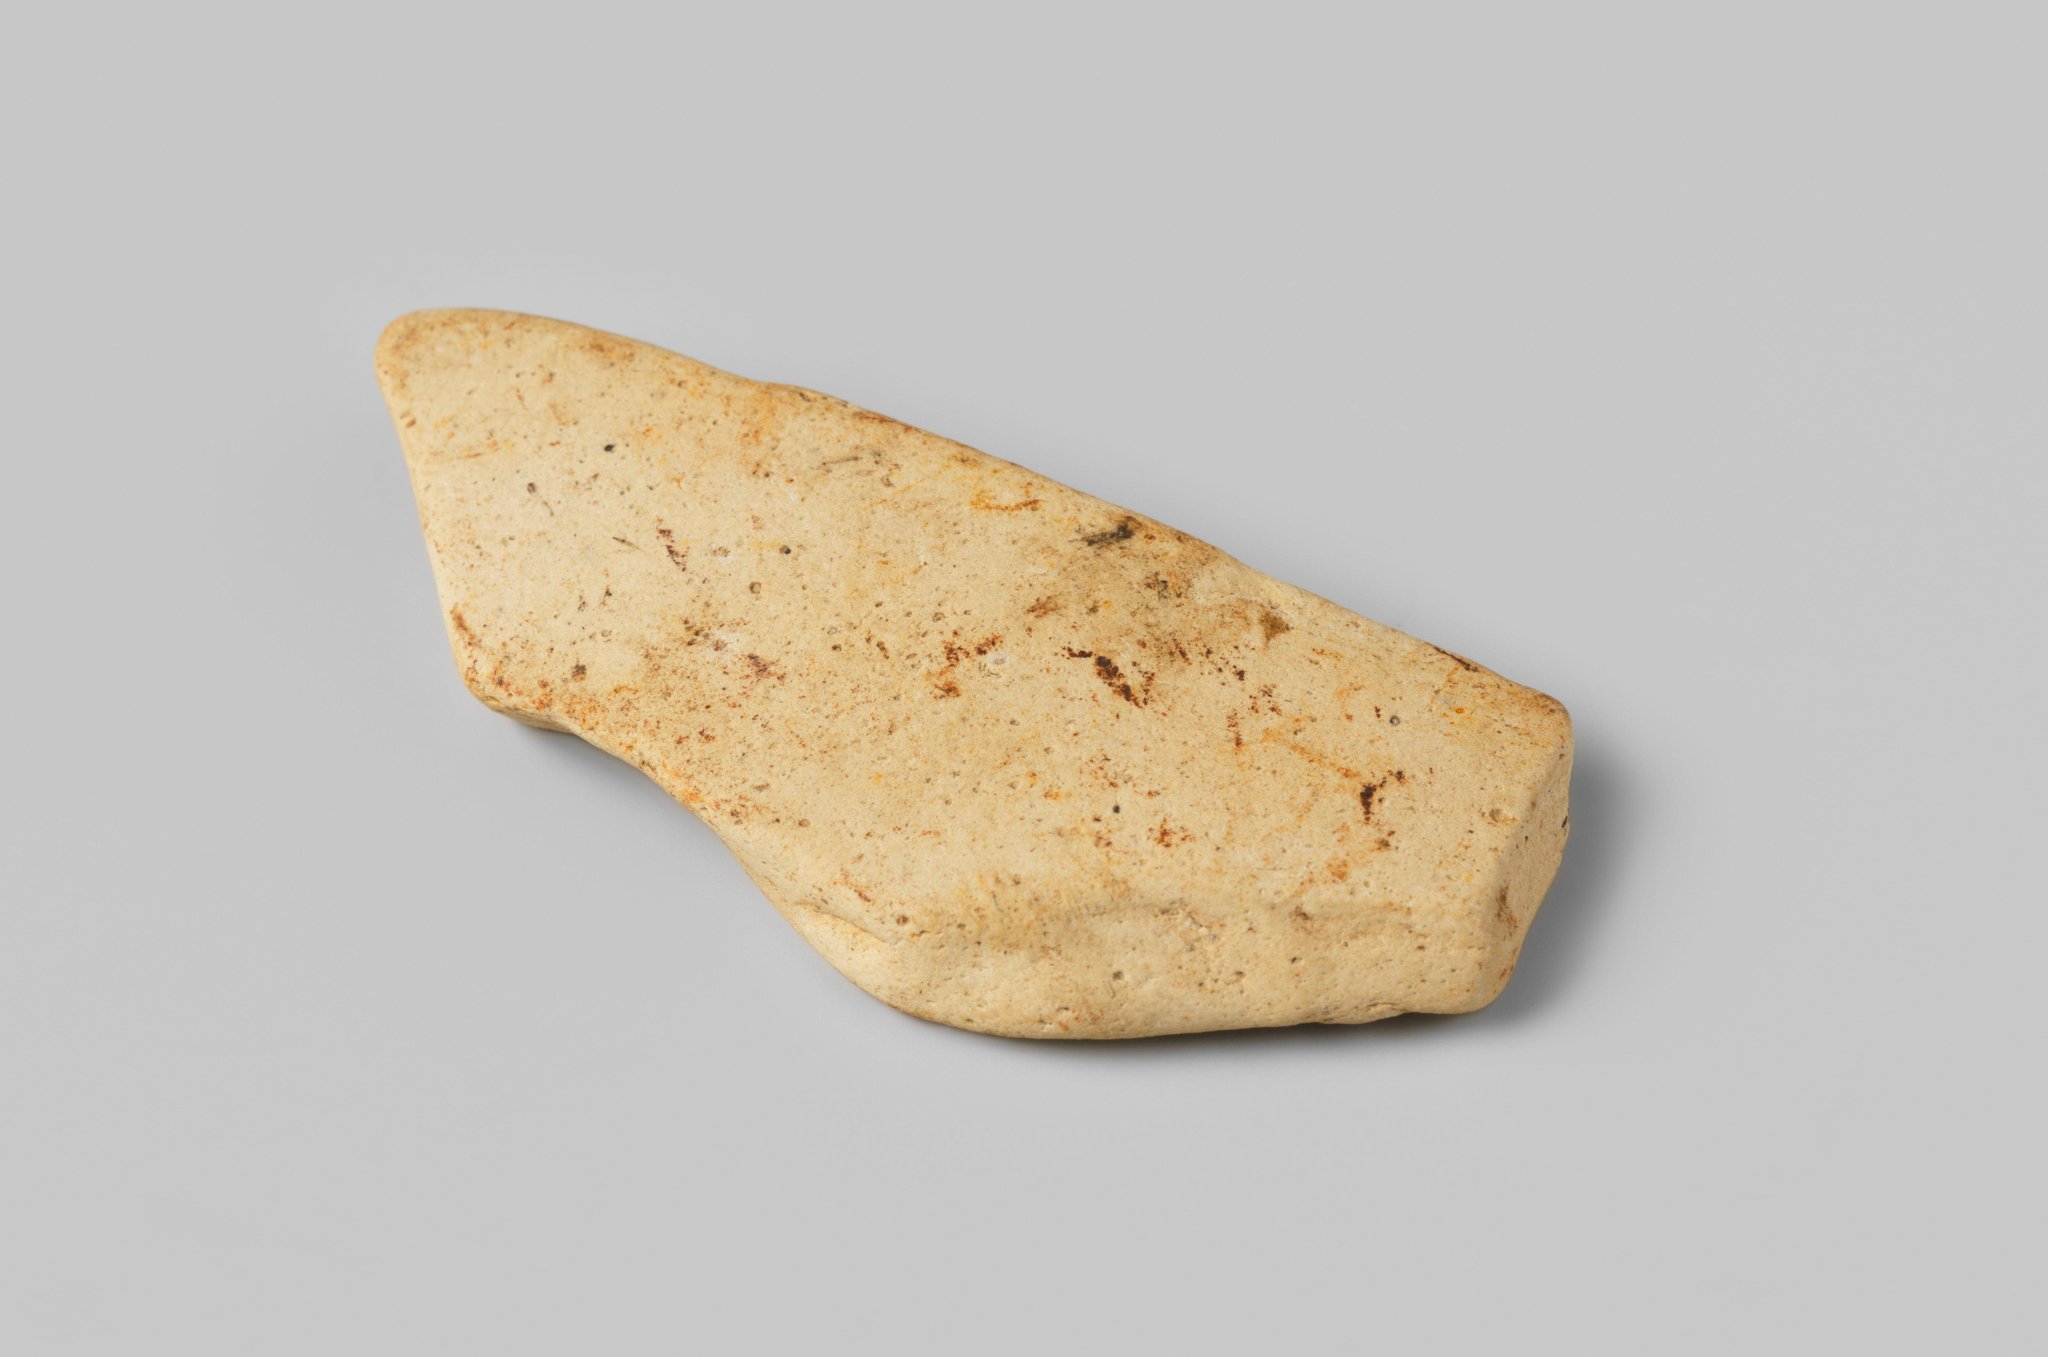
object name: sherd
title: Scherf aardewerk uit het wrak van de Oostindiëvaarder Hollandia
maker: Anonymous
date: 1700-1743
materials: earthenware